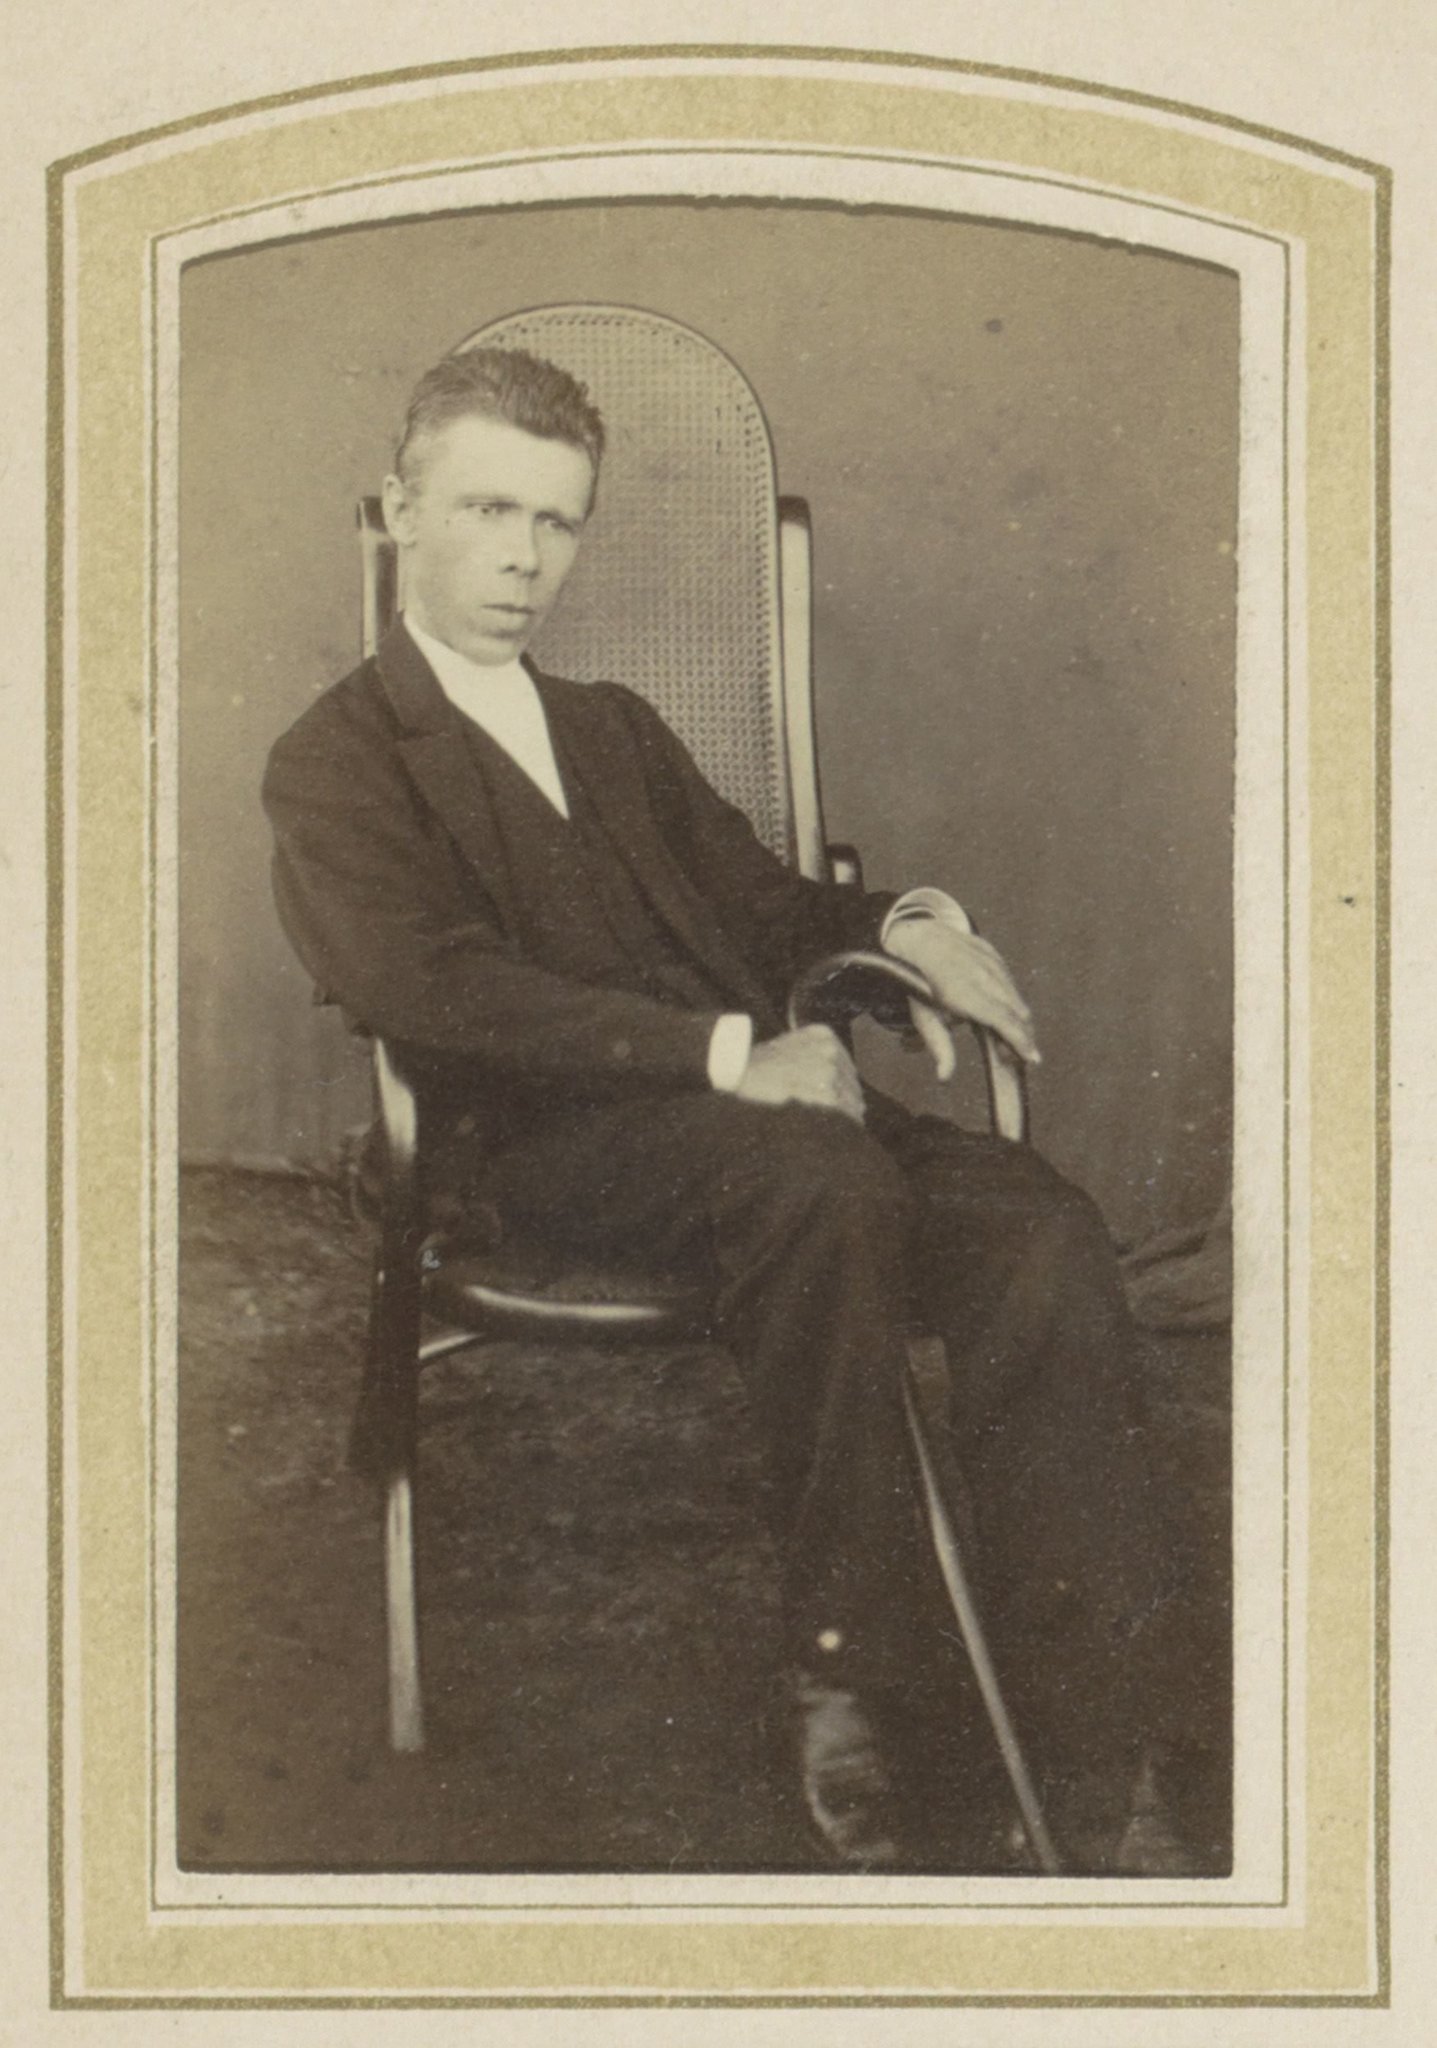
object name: carte de visite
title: Portret van een zittende man met een wandelstok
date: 1881-1900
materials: cardboard, paper, photographic support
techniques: albumen print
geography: arnhem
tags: studio requisites ~ photographer, clothing for the lower part of the body, walking-stick, staff, historical persons, clothing for the upper part of the body, hairdress, arnhem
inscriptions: address: ‘Arnhem Menthensteeg No. 252’, address: ‘Arnhem’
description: Onderdeel van Fotoalbum van een Nederlandse familie met 168 cartes-de-visite en kabinetfoto's.